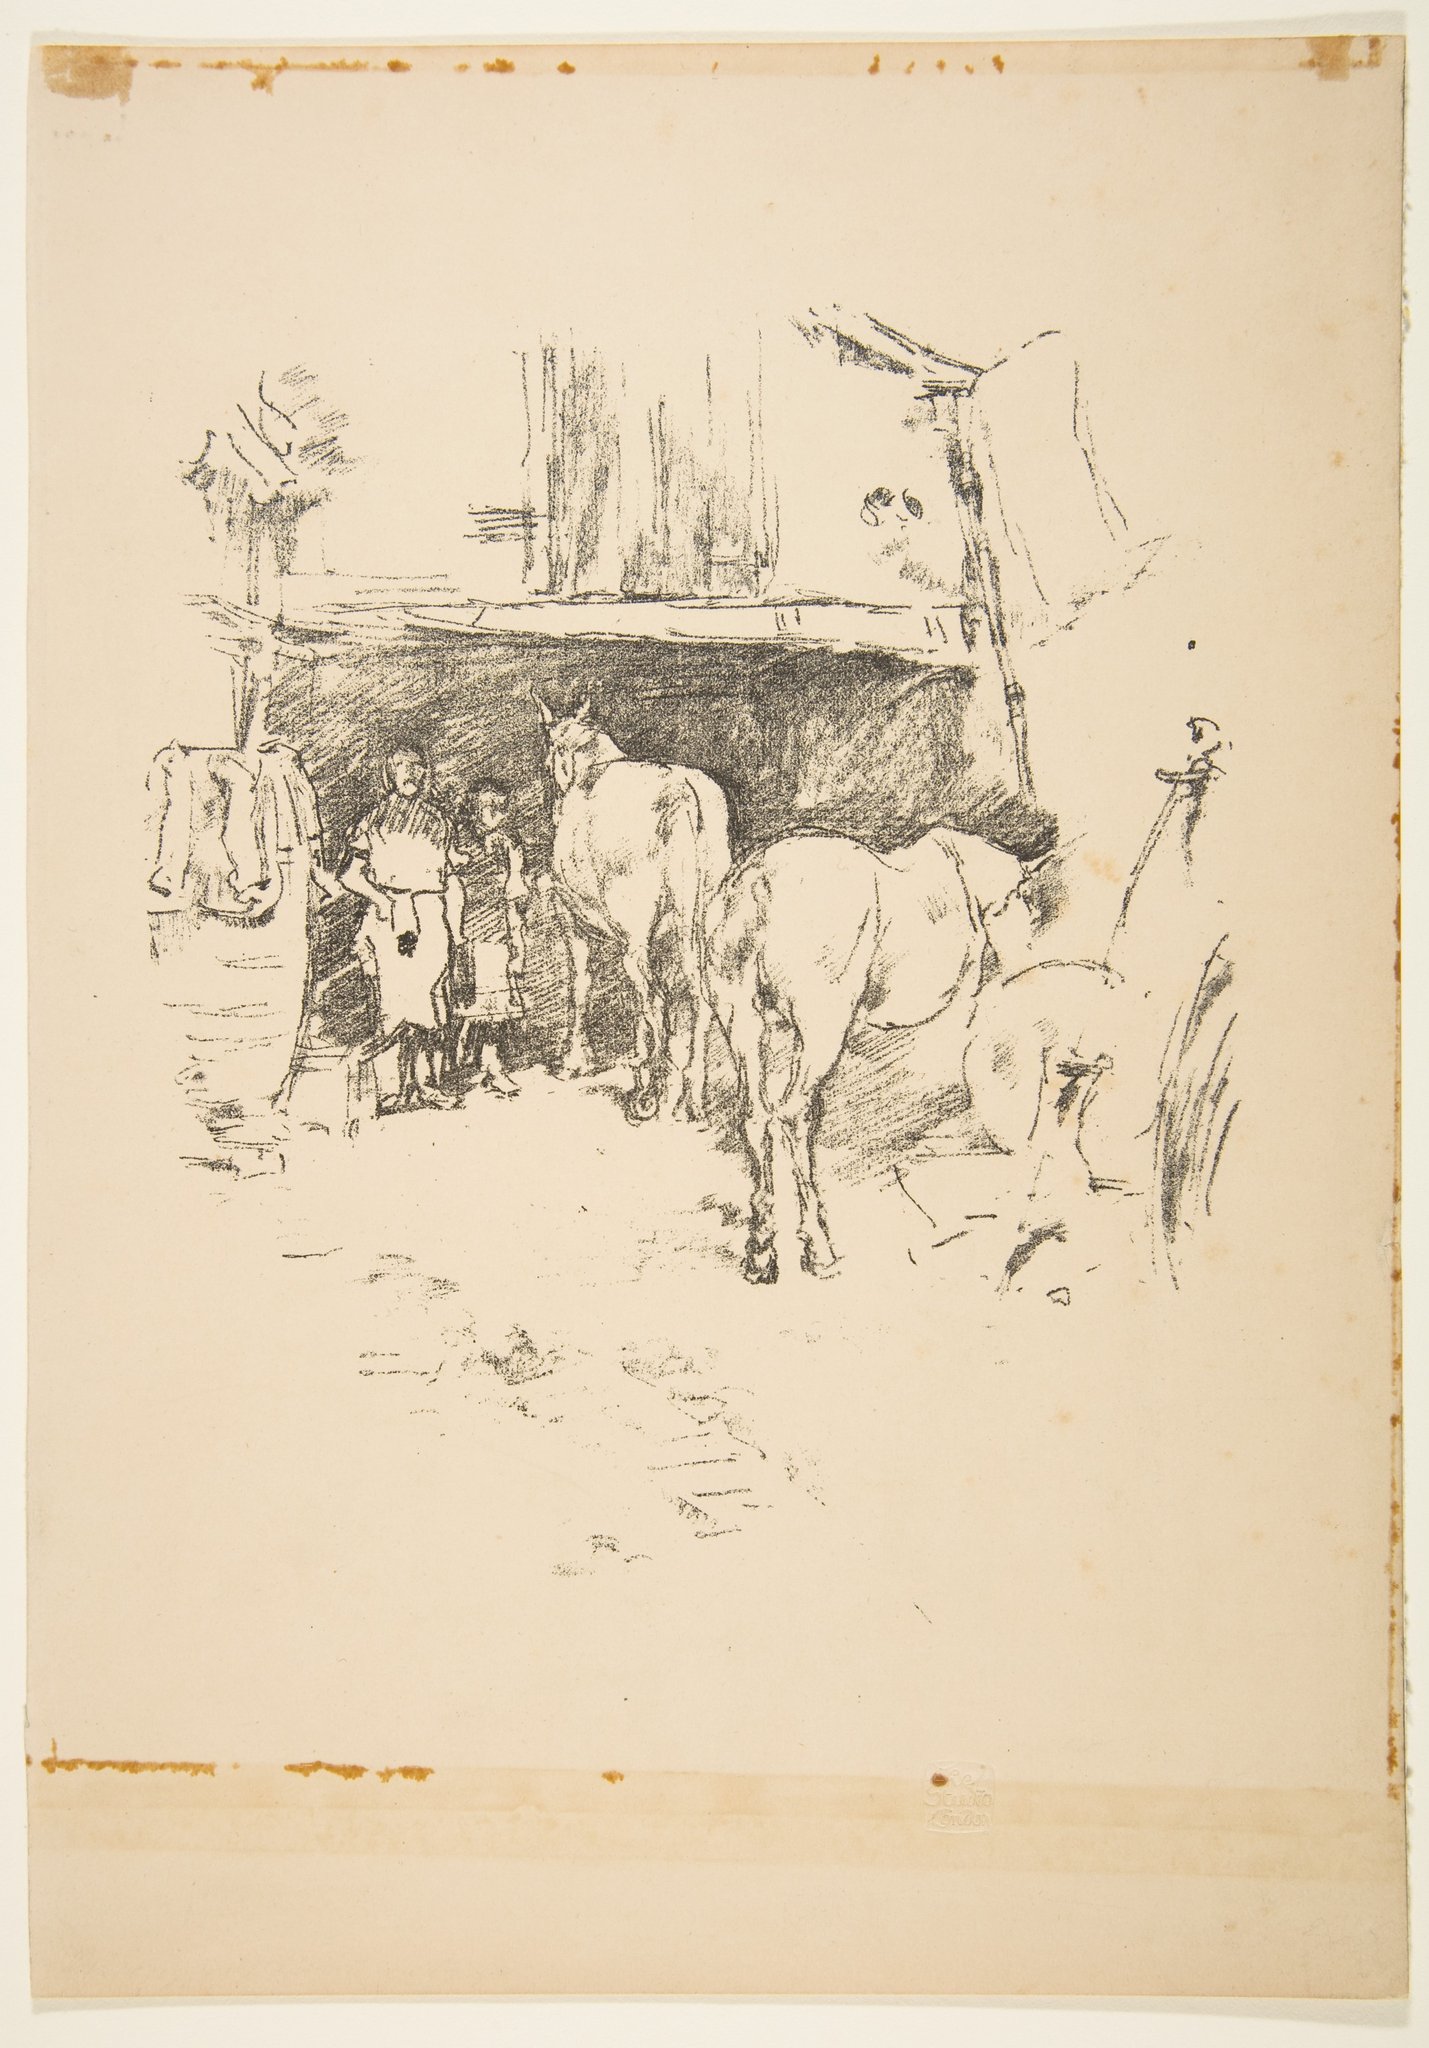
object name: print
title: The Smith's Yard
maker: james mcneill whistler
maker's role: artist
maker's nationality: american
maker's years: 1834-1903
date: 1895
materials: stone, paper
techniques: printing, lithography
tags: human figures,horses